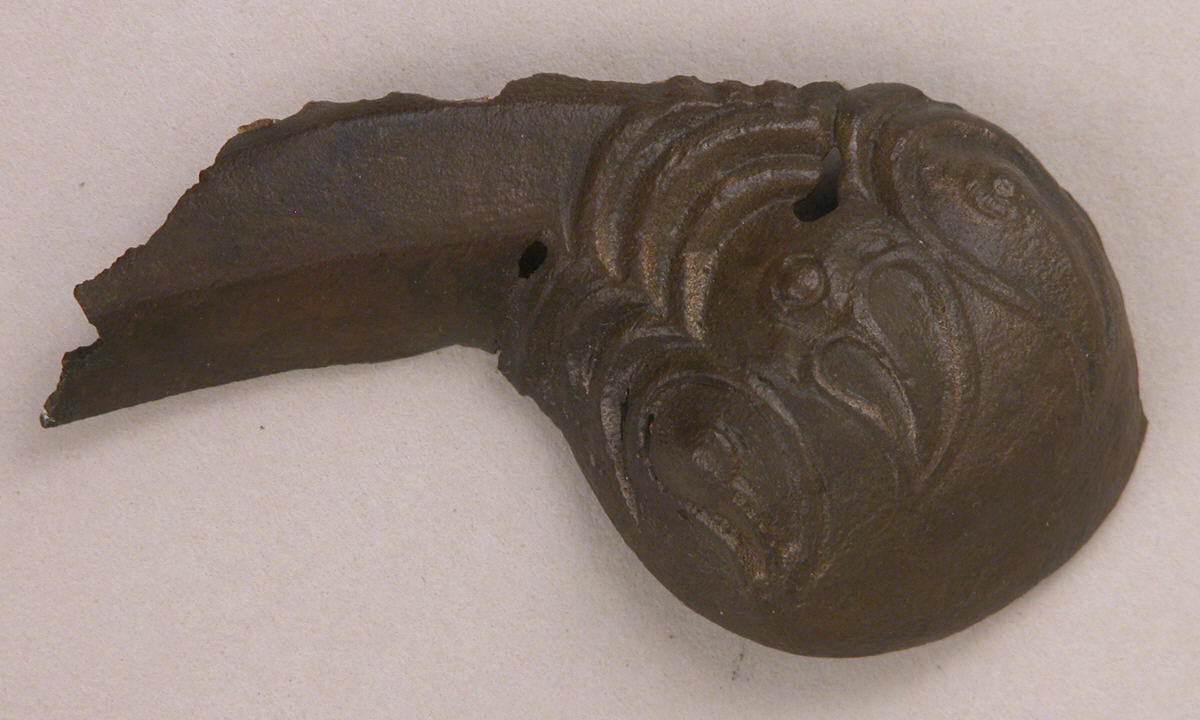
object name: unidentified object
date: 801-1000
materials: bronze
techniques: casting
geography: iran